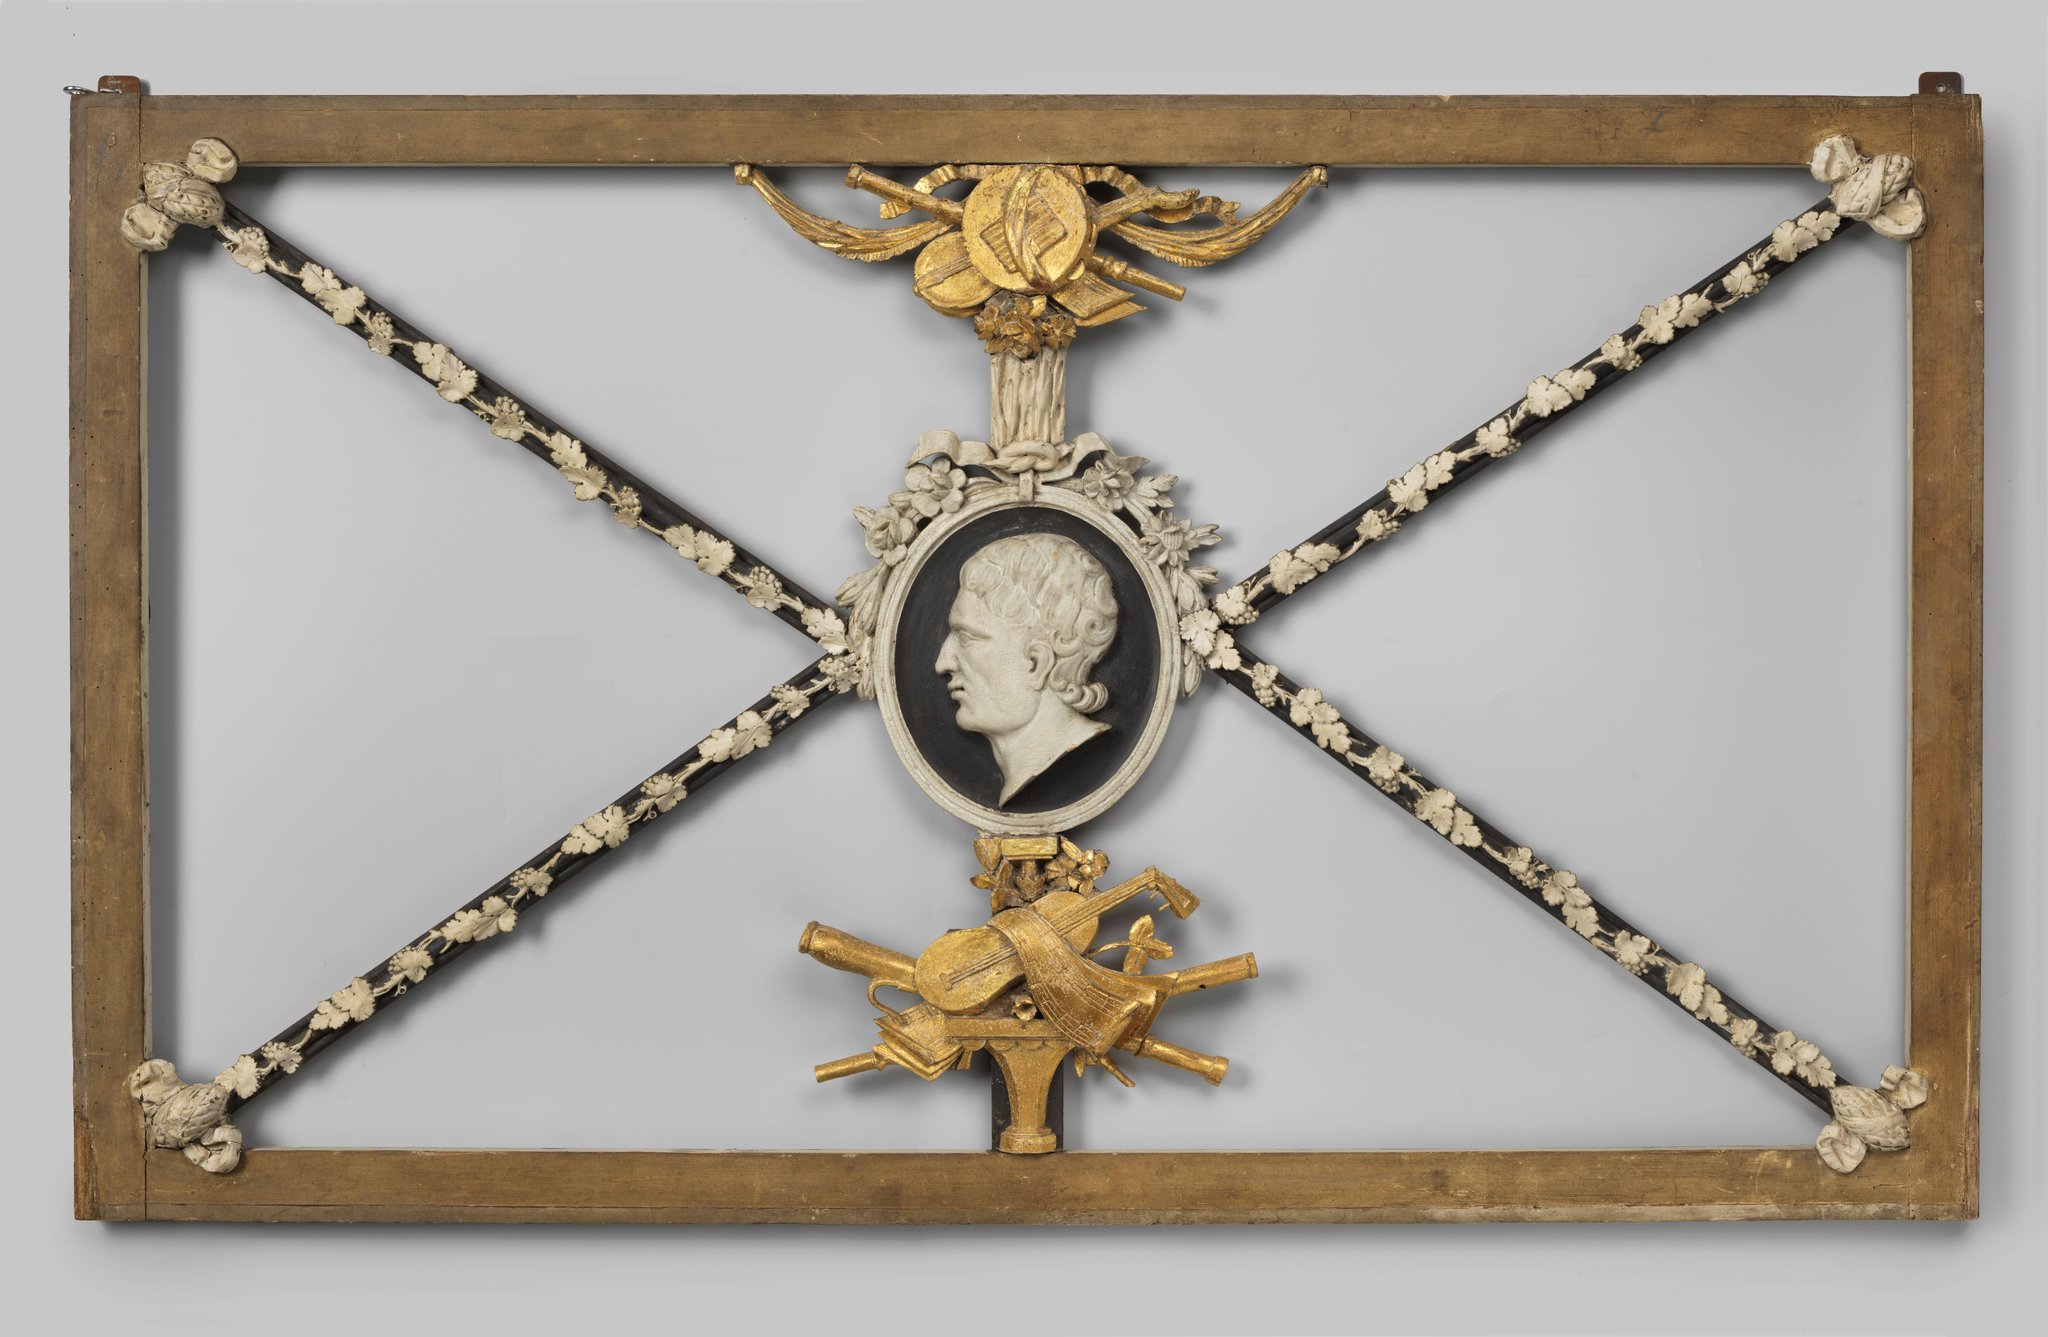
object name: sculpture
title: Bovenlicht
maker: Anonymous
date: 1750-1799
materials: wood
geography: netherlands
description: Bovenlicht, waarin een gesneden medaillon met mannekop en muziekinstrumenten.